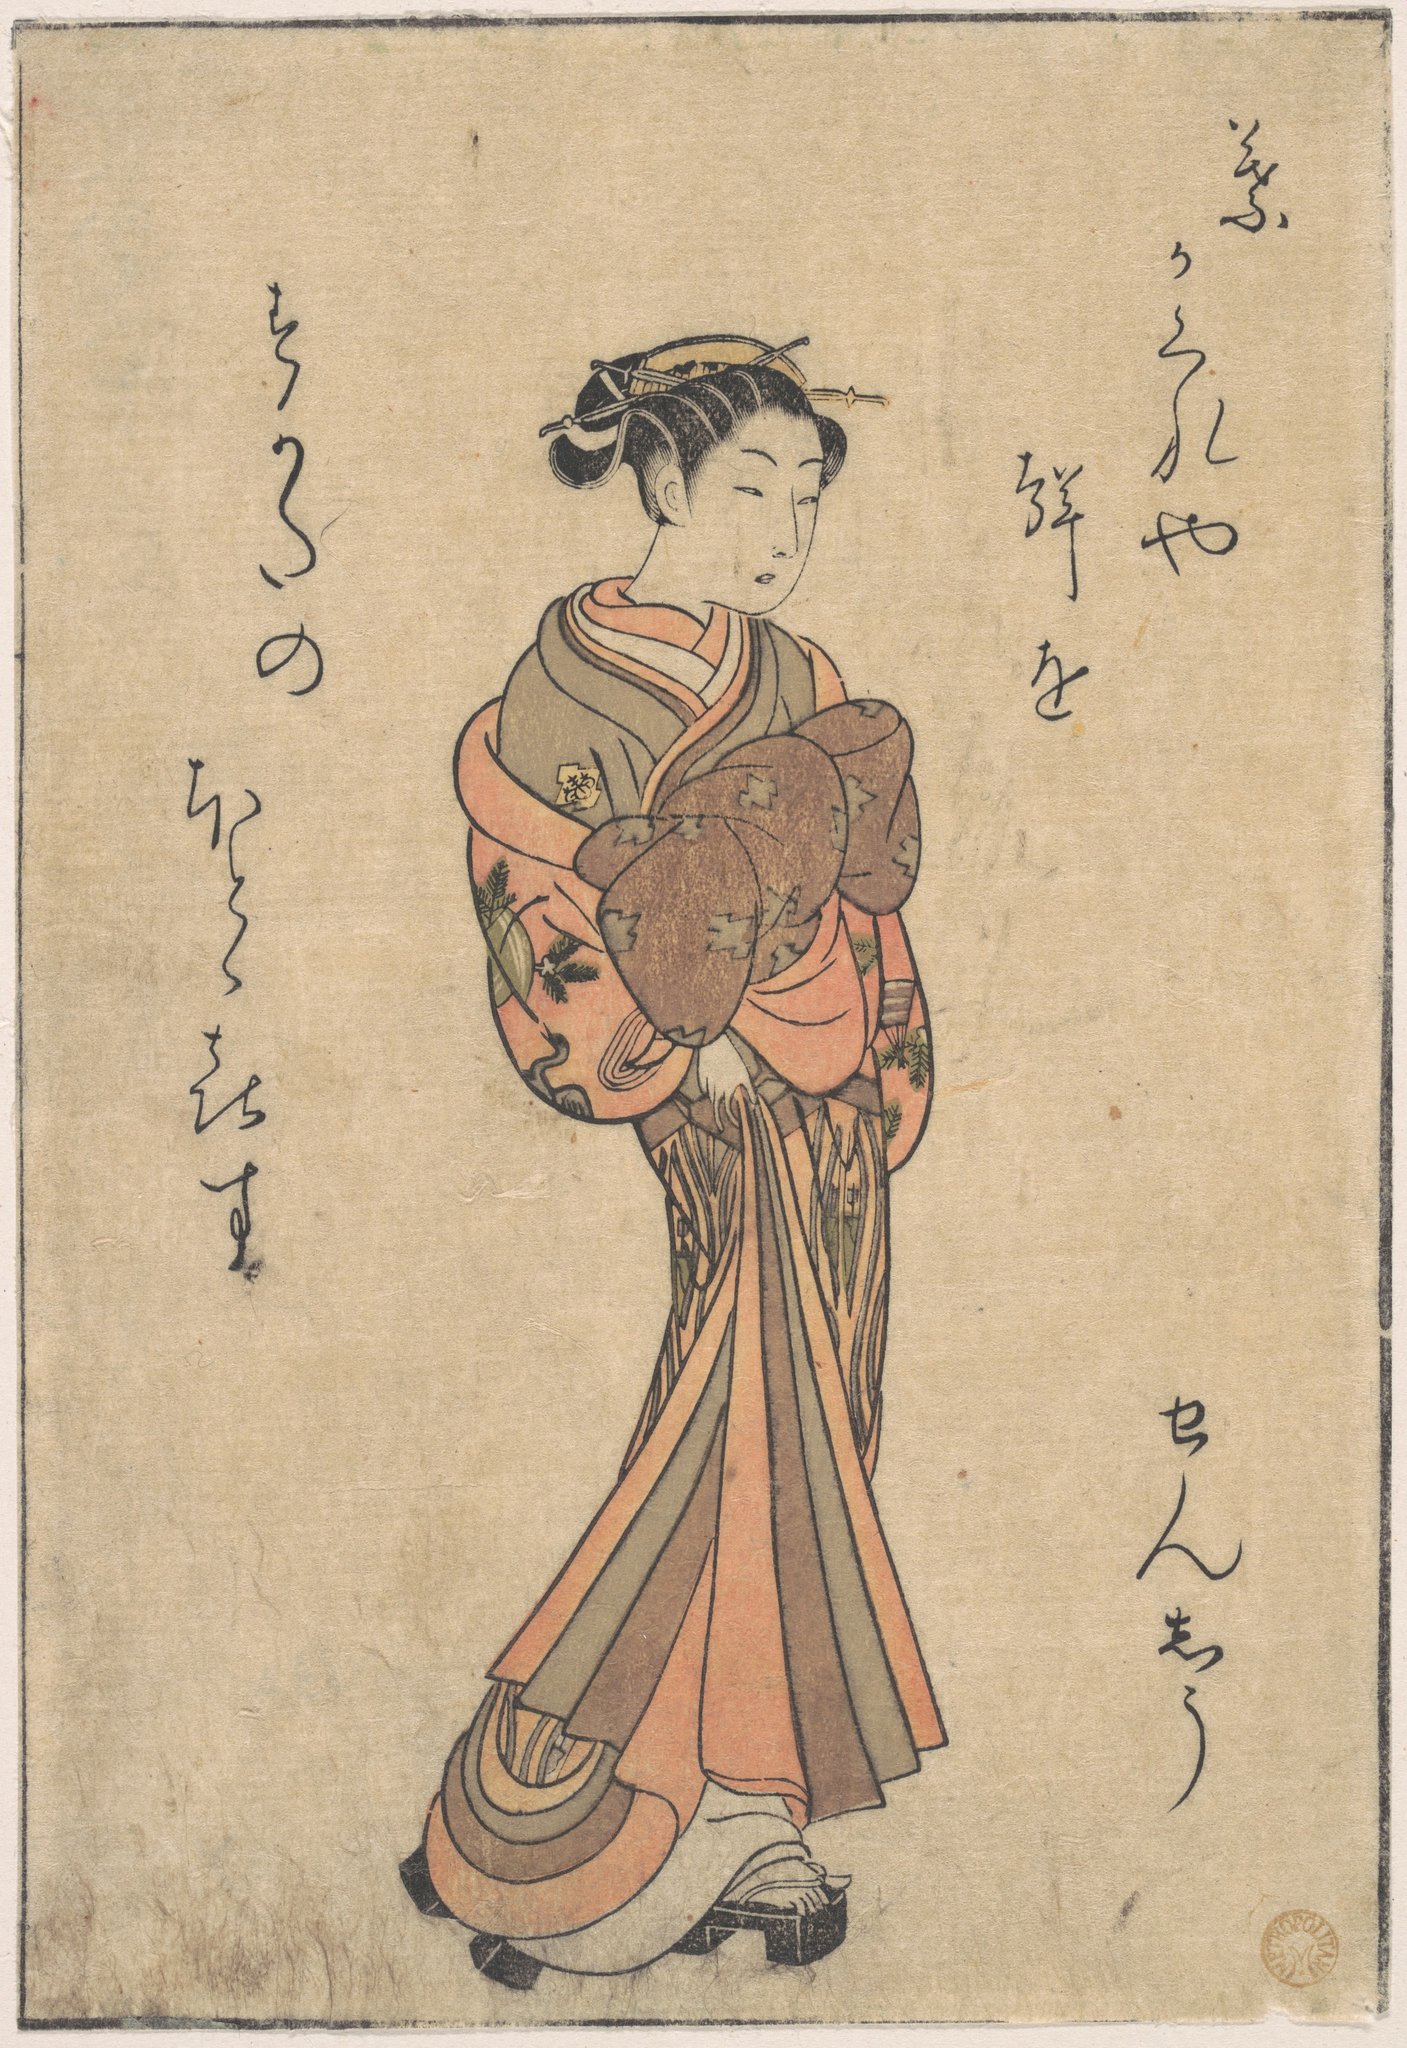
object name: print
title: The Courtesans, from the Series, "Seiro Bijin Awase Carver End Shigoro" (sic.)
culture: japanese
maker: suzuki harunobu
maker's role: artist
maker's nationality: japanese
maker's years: 1725-1770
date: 1765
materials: ink, paper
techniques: woodblock print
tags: women